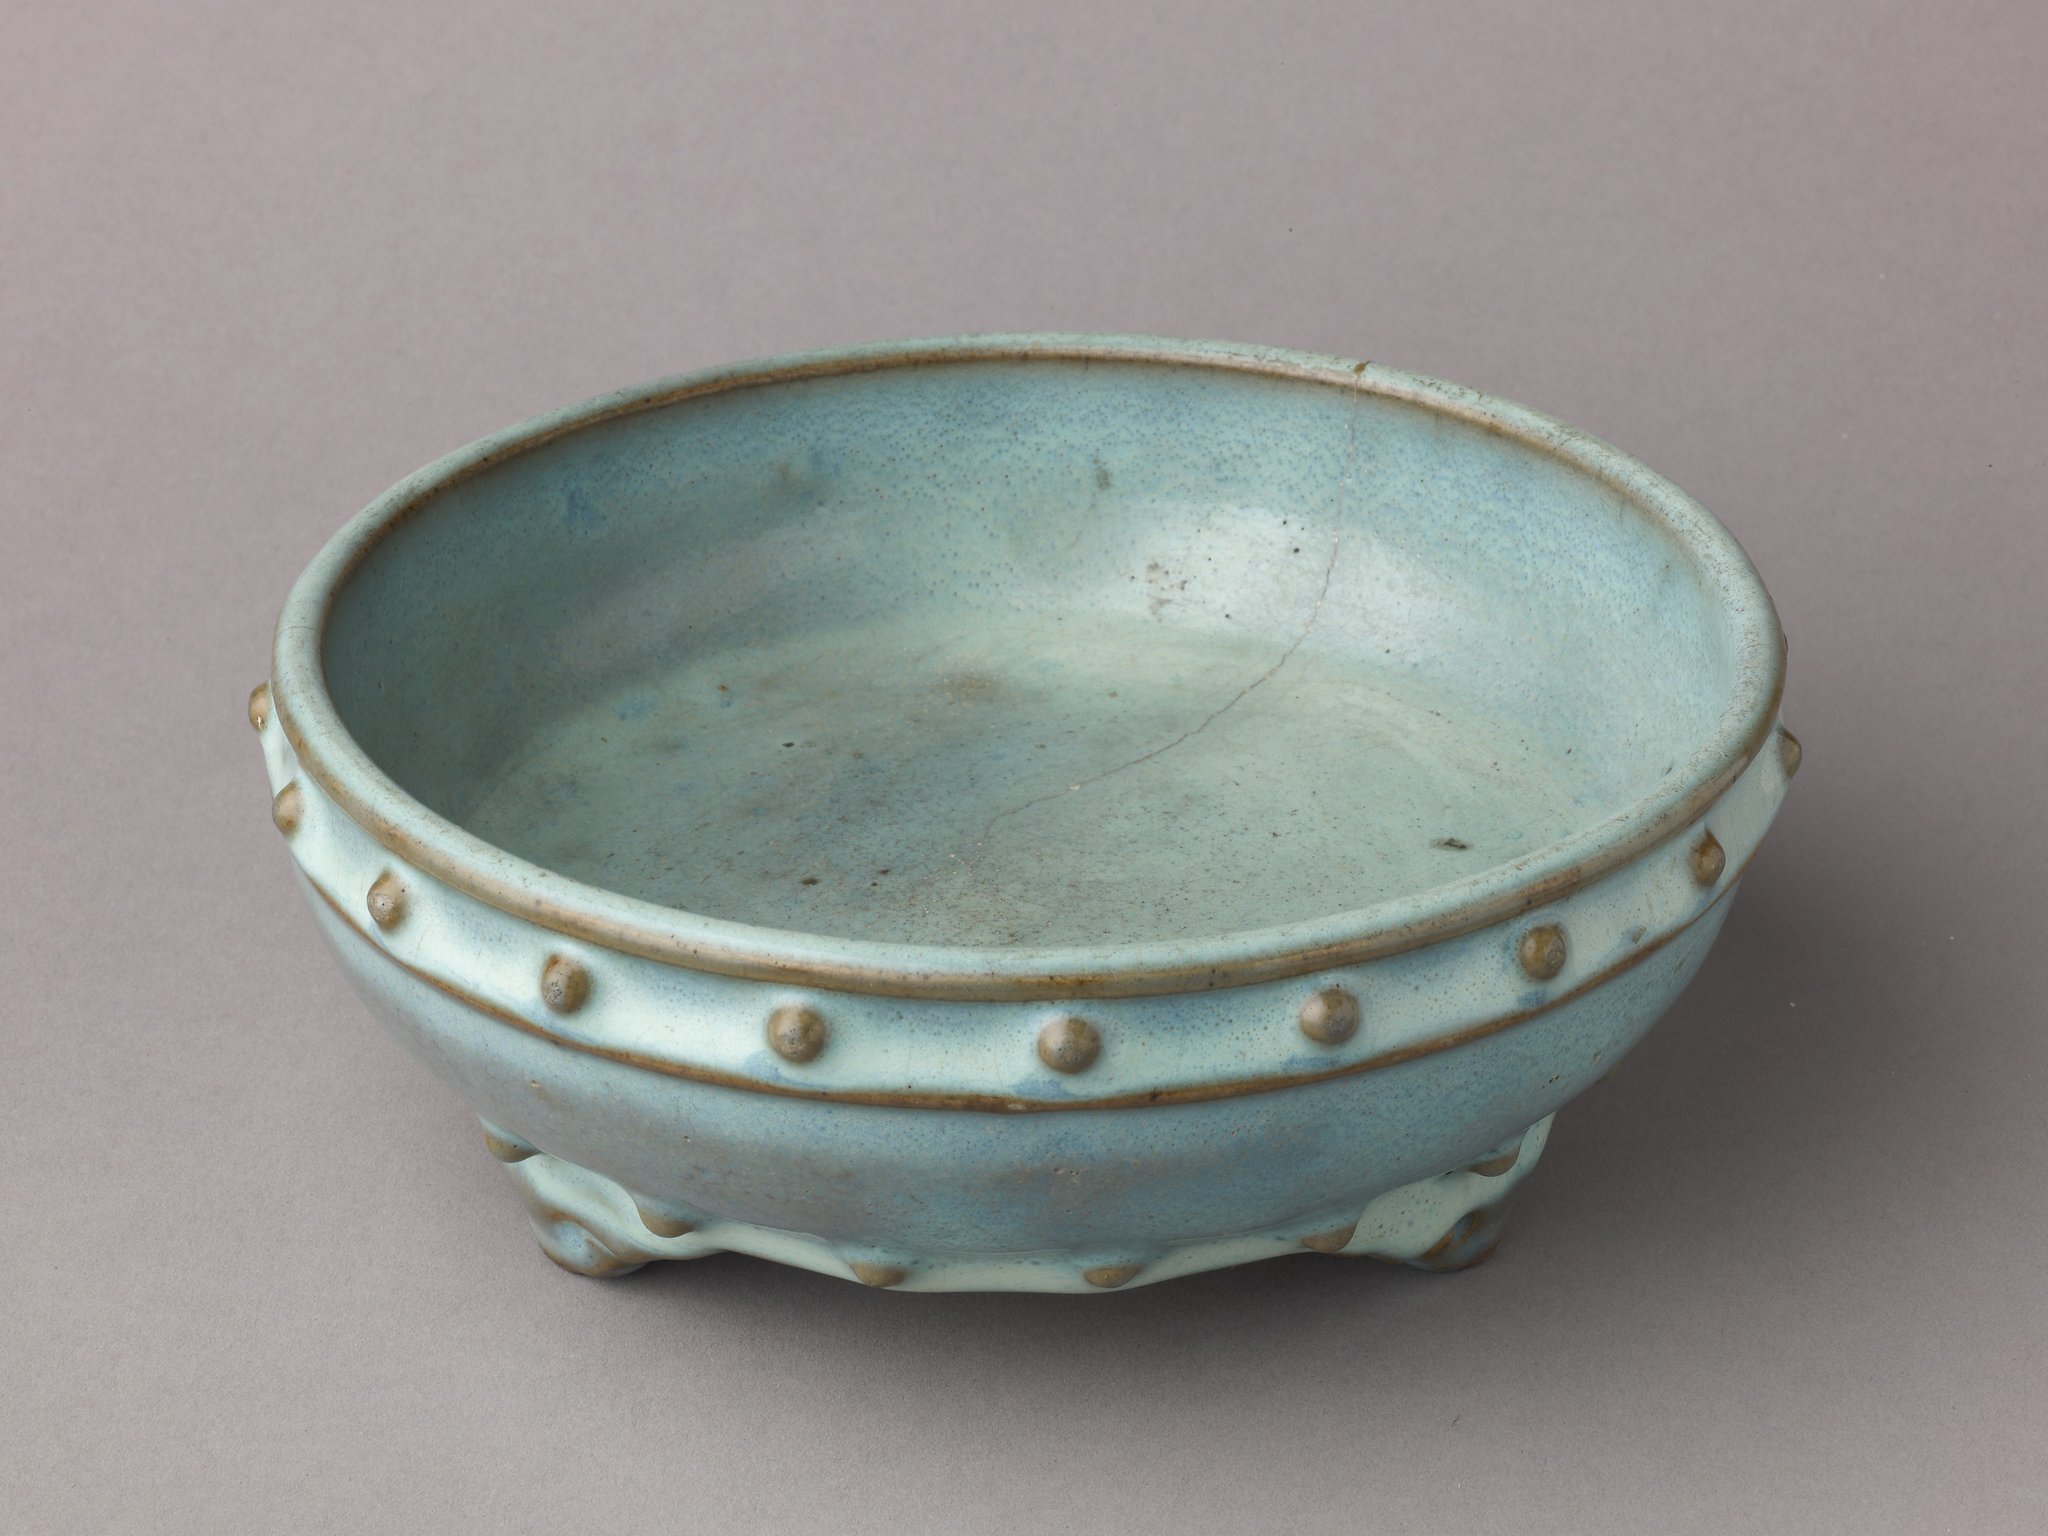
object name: bowl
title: Bulb bowl, Numbered Jun ware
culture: chinese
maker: chinese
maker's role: artist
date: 1201-1400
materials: glaze, stoneware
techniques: relief